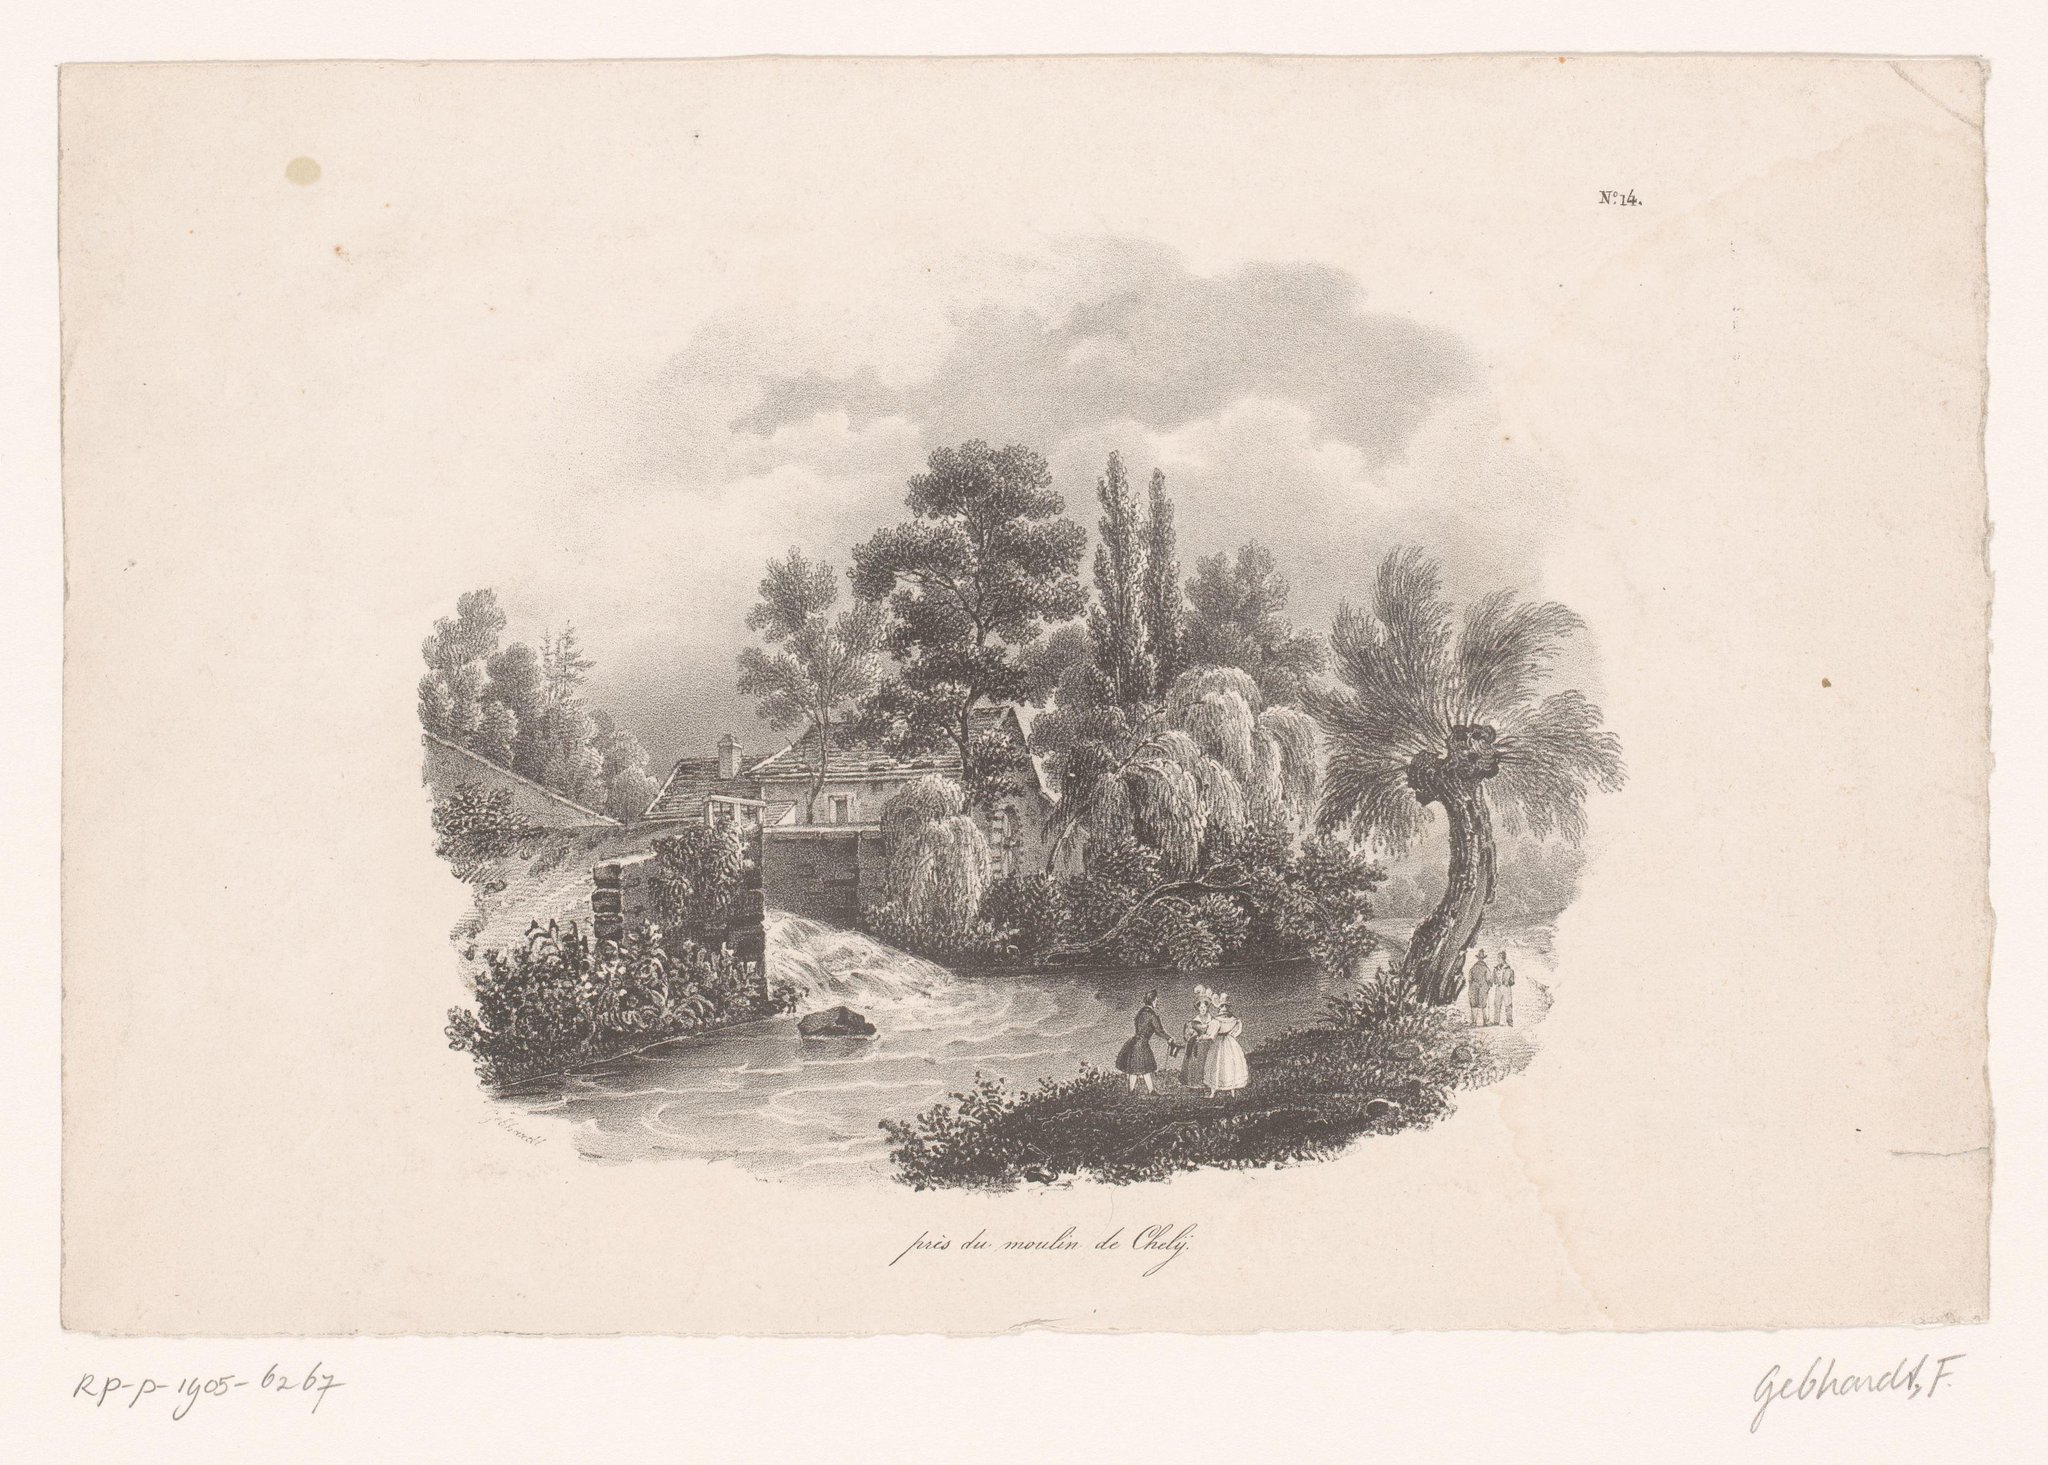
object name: print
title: Près du moulin de Chely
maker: françois gebhardt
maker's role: print maker, printer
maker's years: 1796-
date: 1837-1855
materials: paper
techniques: lithograph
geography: paris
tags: watermill, river (+ landscape with figures, staffage)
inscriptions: collector's mark: Lugt 2228a